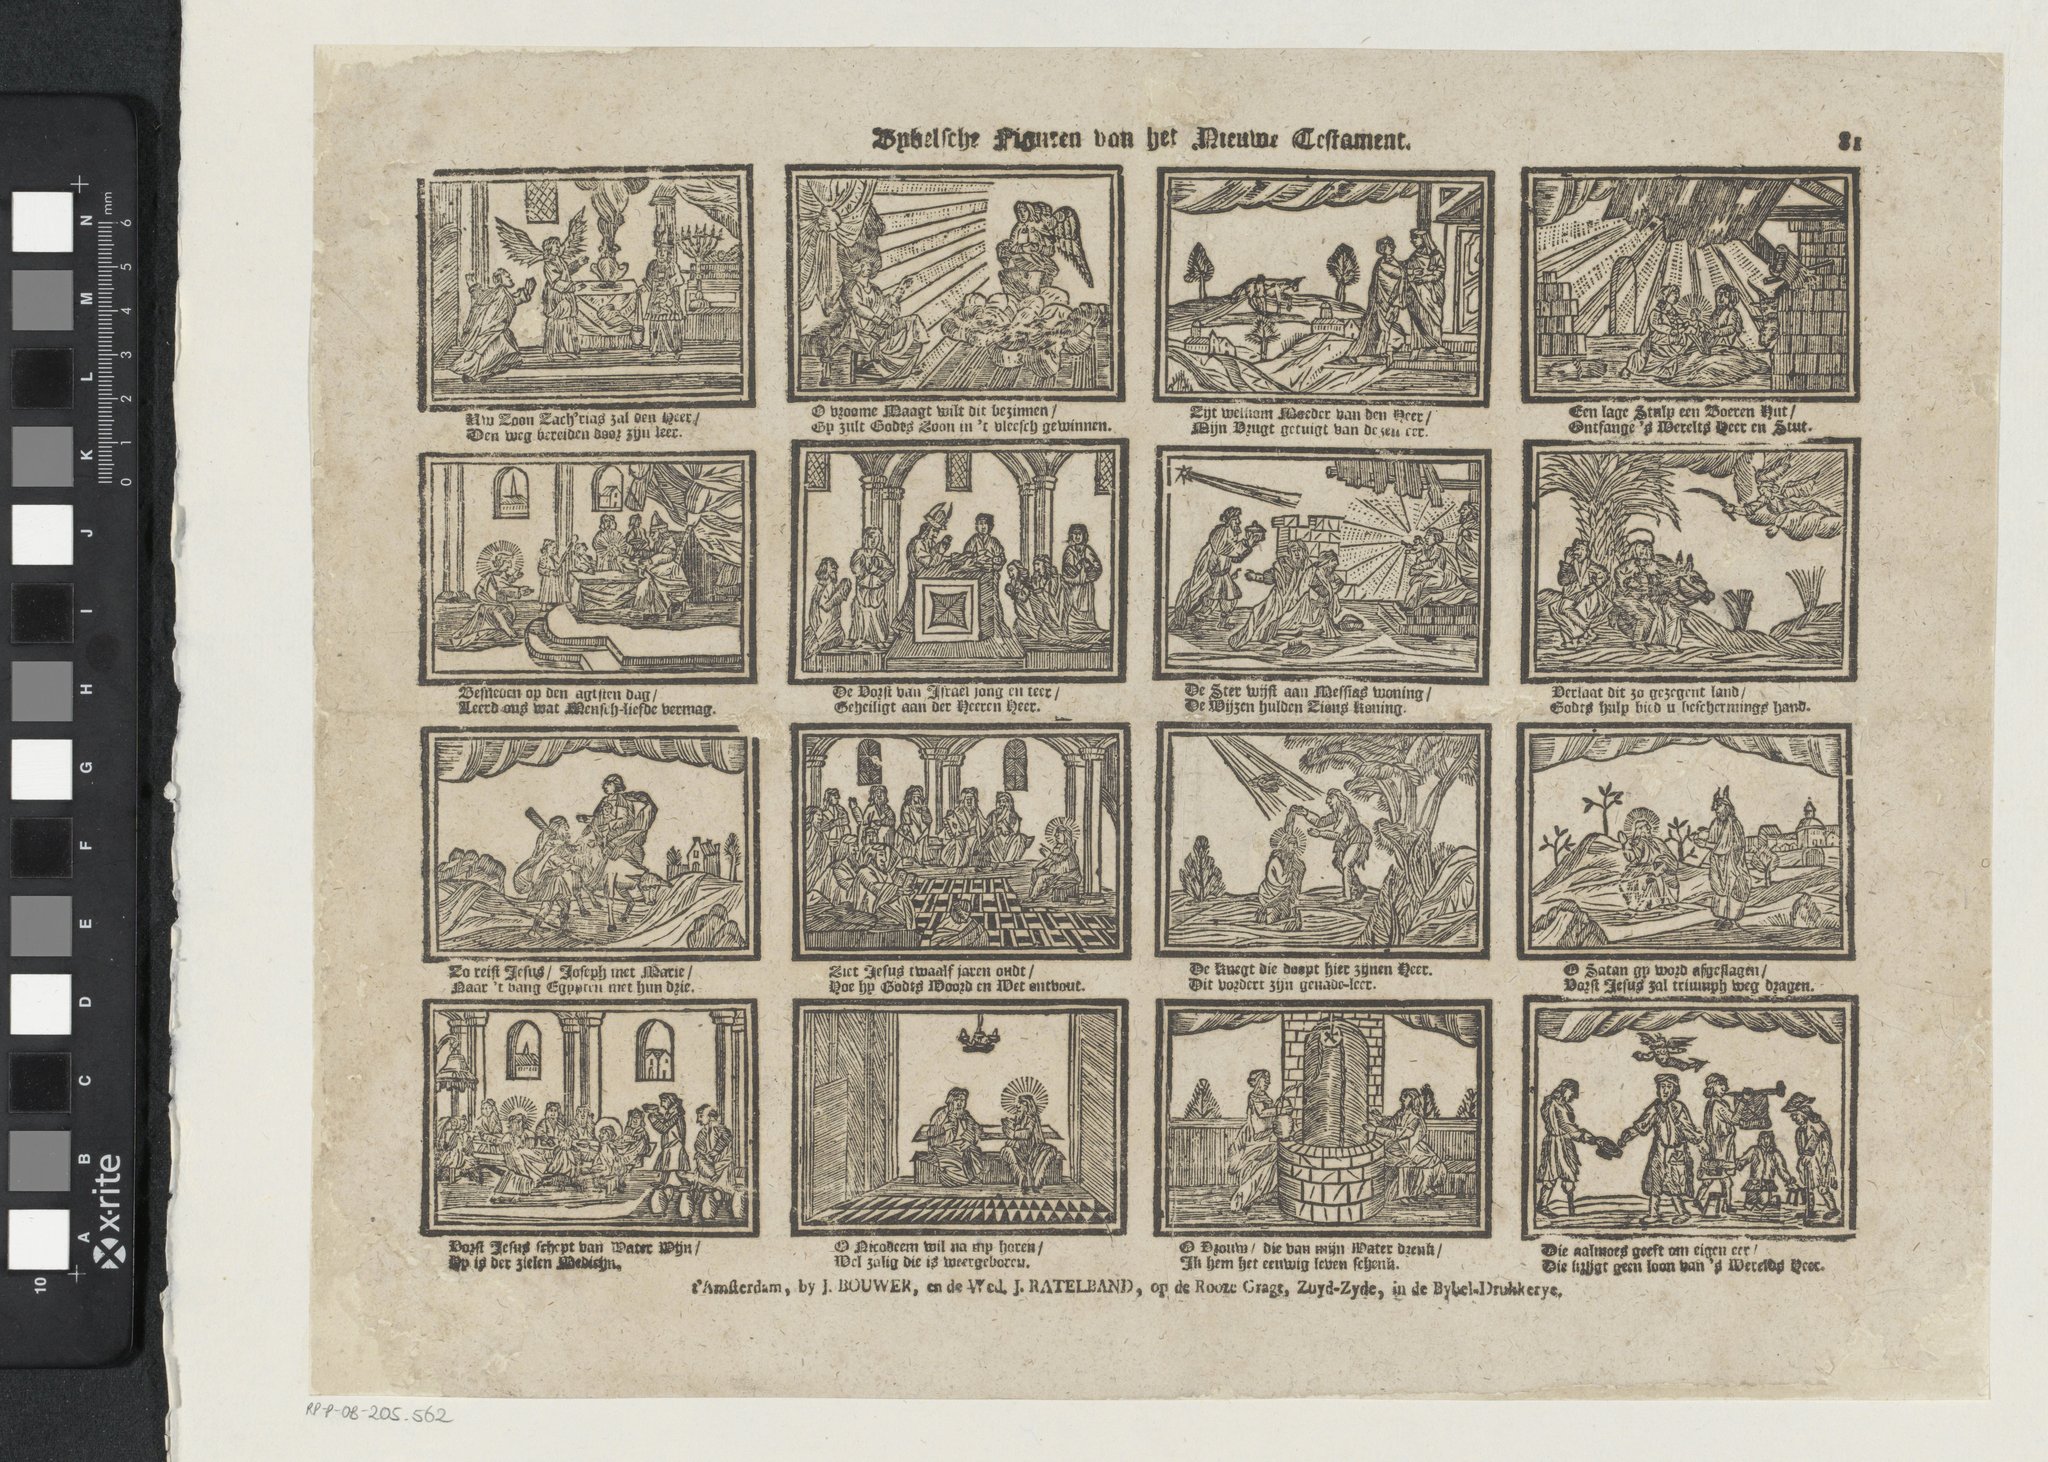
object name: popular print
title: Bybelsche figuren van het Nieuwe Testament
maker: Anonymous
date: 1794-1804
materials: paper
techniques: letterpress printing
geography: amsterdam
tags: new testament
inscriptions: collector's mark: Lugt 2760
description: Blad met 16 voorstellingen van verhalen uit het Nieuwe Testament. Onder elke afbeelding een tweeregelig vers. Genummerd rechtsboven: 81.